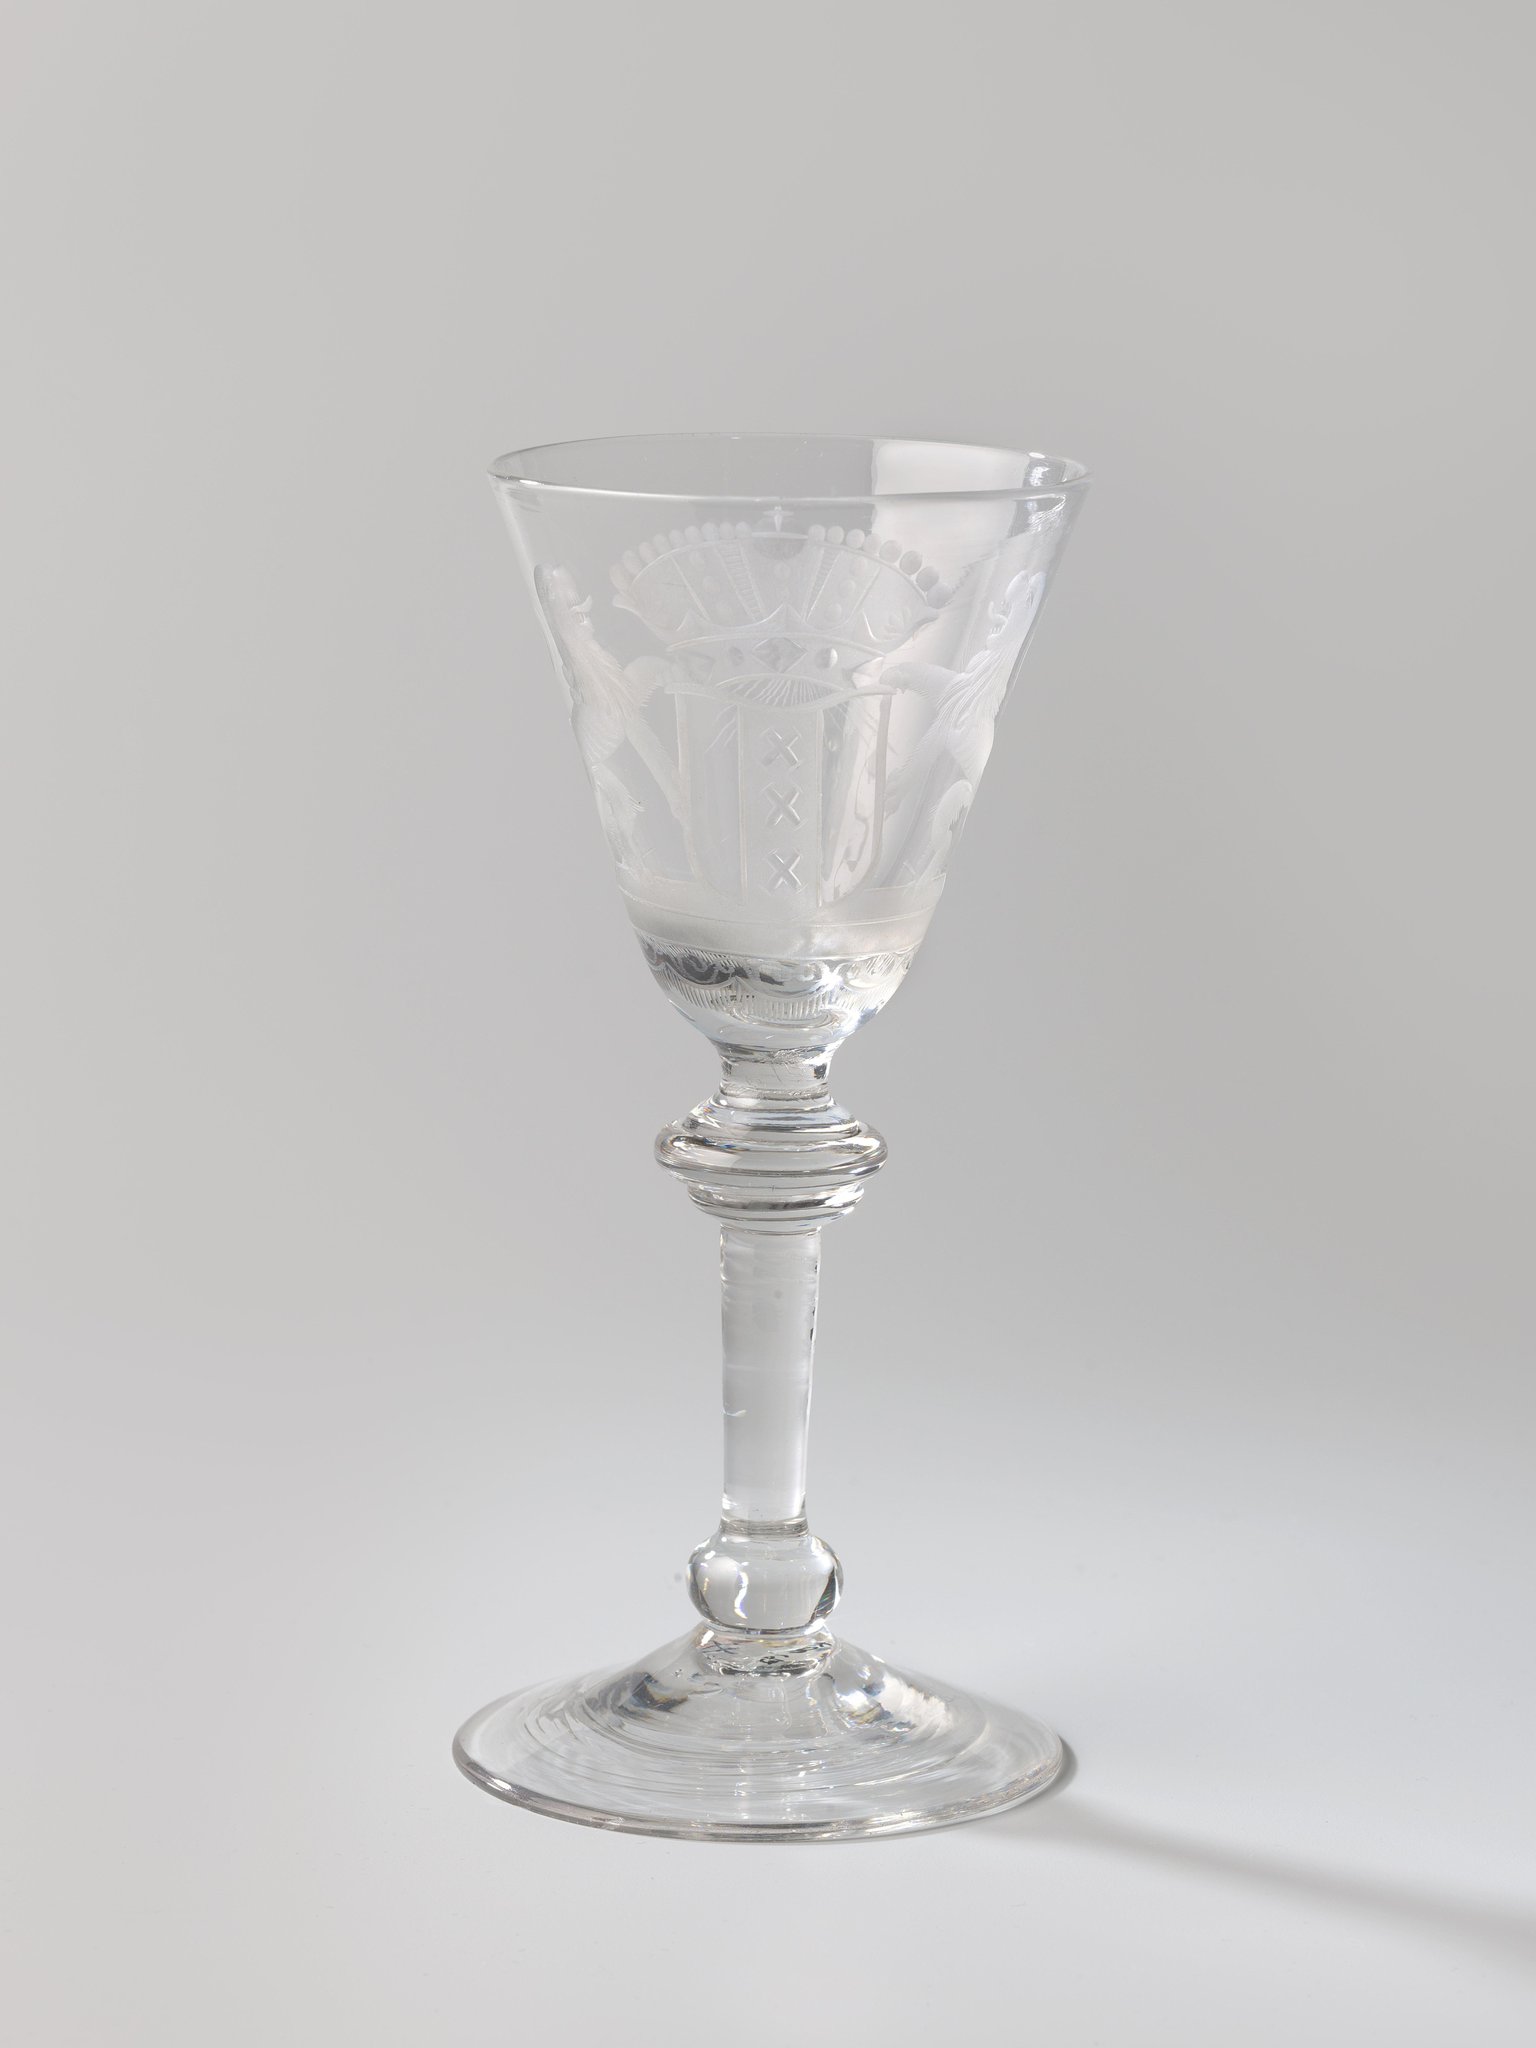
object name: goblet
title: Kelkglas met het wapen van de stad Amsterdam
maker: Anonymous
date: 1750-1775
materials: glass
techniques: glassblowing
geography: northern netherlands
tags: amsterdam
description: Conische voet. Rechte stam met een gladde en een samengestelde knoop. Trechtervormige kelk met een afgeronde onderzijde. Op de kelk, op een trapvormig voetstuk met een afhangende lambrequin met franje, het gekroonde wapen van de stad Amsterdam, geflankeerd door twee leeuwen. Op de keerzijde een stralende zon.